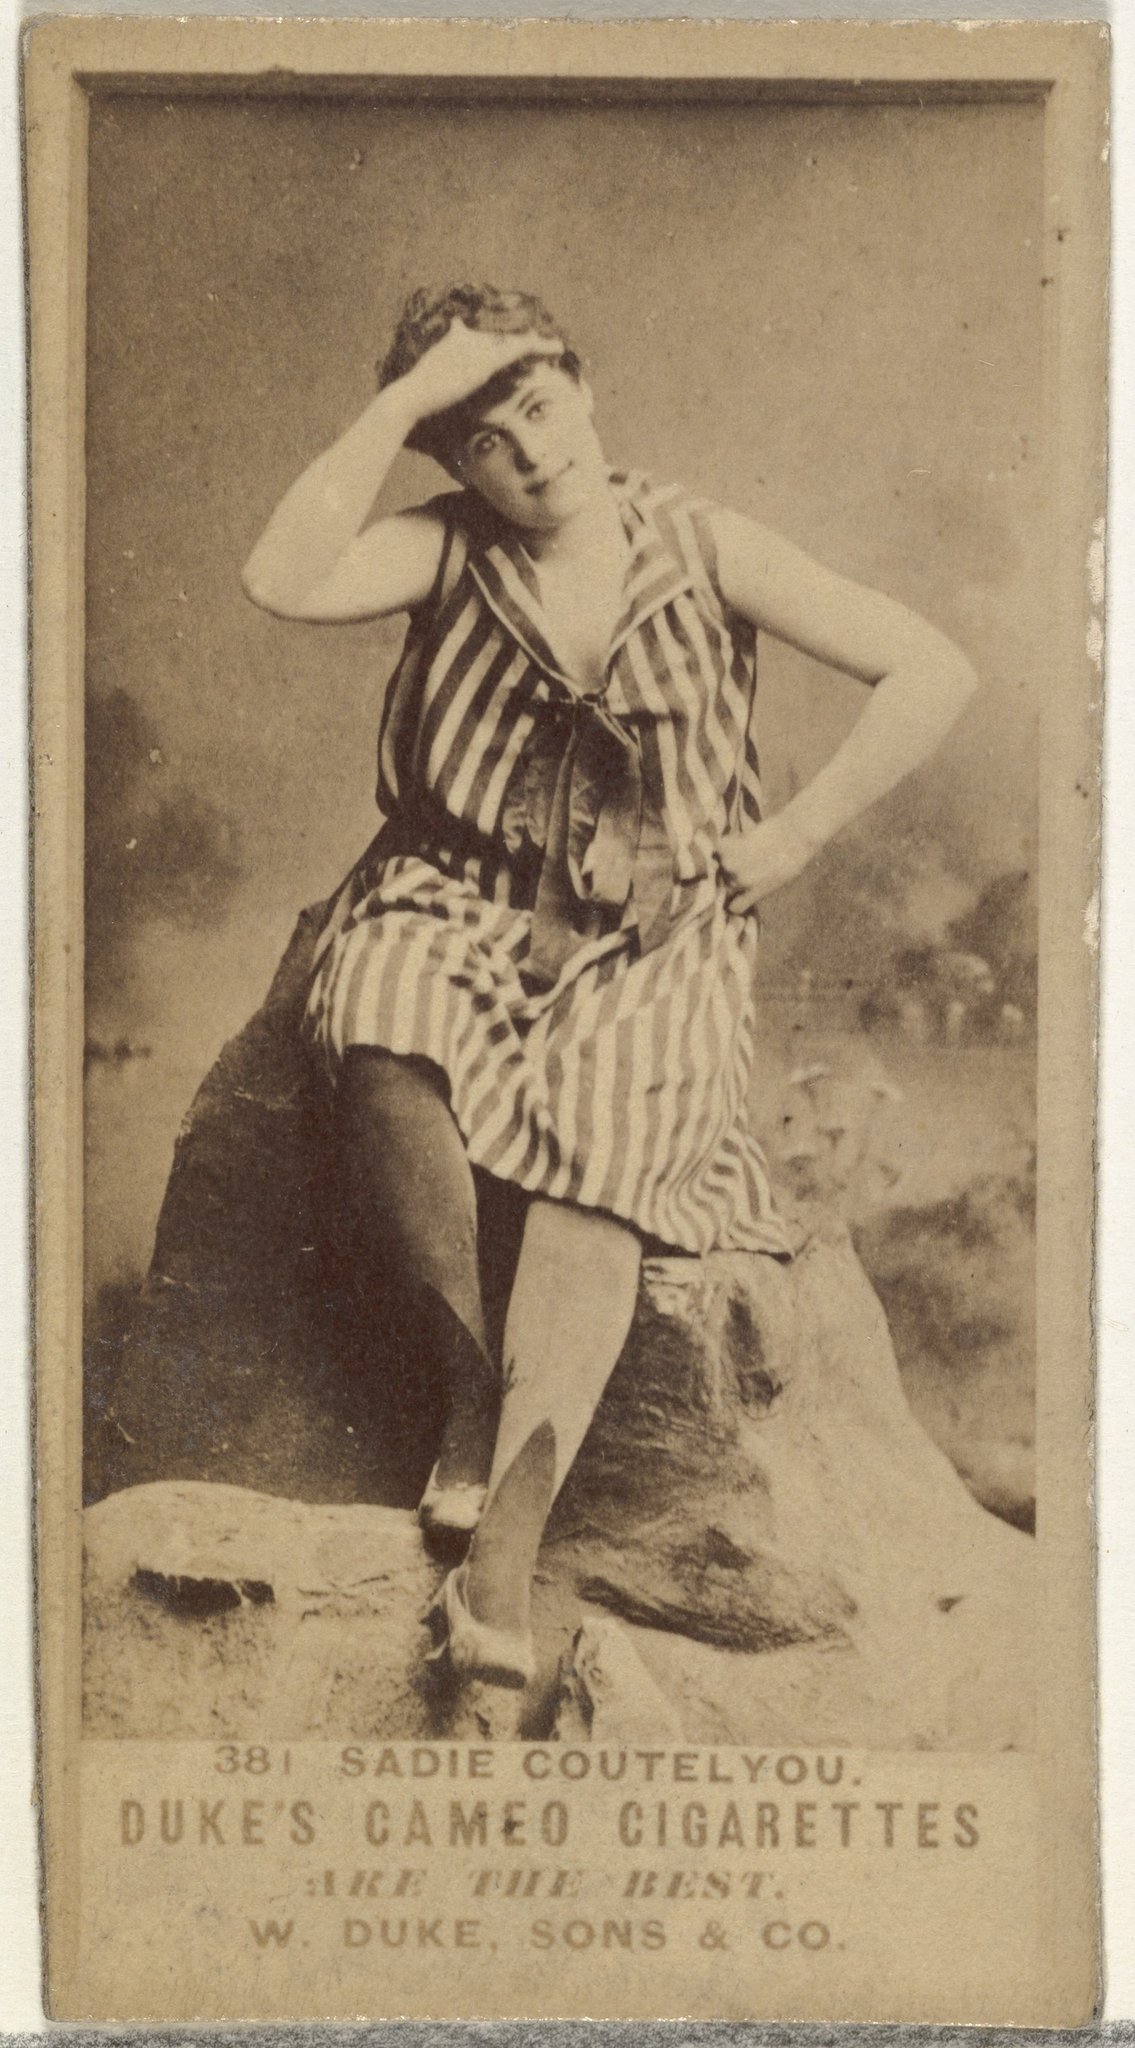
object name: photograph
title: Card Number 381, Sadie Coutelyou, from the Actors and Actresses series (N145-5) issued by Duke Sons & Co. to promote Cameo Cigarettes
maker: w. duke, sons & co.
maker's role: publisher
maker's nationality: american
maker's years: 1870-1920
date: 1880-1889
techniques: albumen silver print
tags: portraits,women,actresses